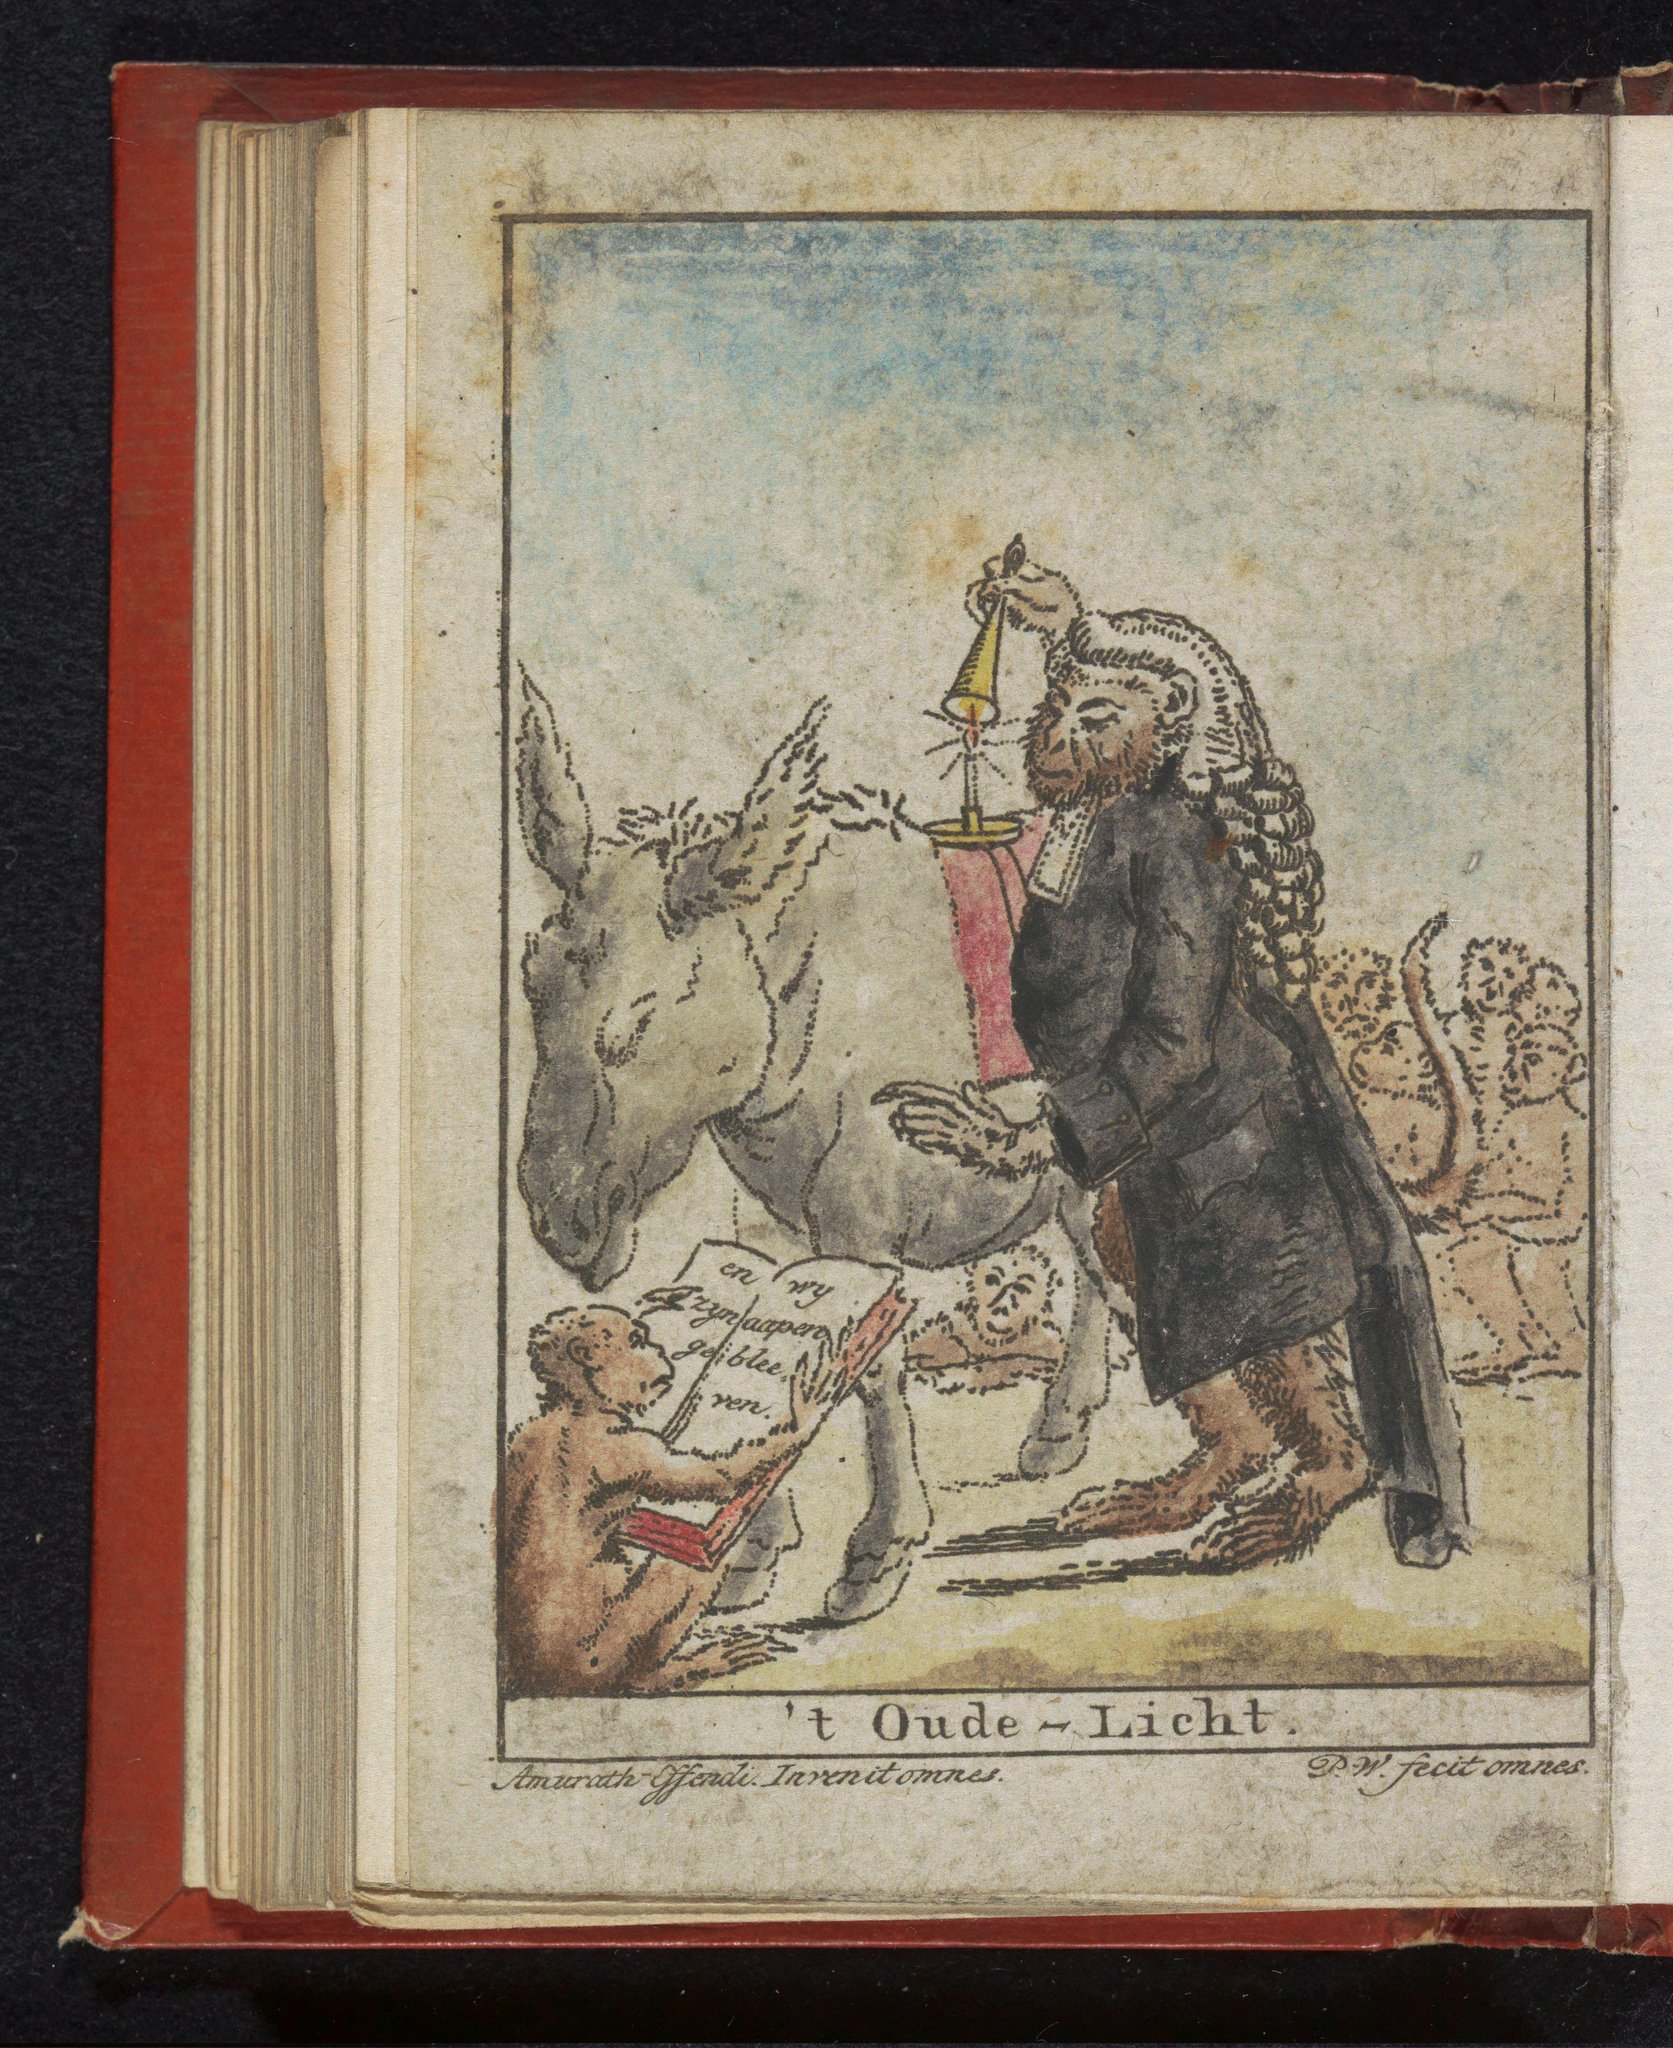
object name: print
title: 't Oude-Licht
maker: pieter van woensel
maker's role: print maker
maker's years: 1747-1808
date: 1795-1796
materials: paper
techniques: etching, hand coloring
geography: netherlands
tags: ass, donkey, monkeys, apes, animals acting as human beings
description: Spotprent waarin een aap met pruik en domineesmantel de kaars op de rug van ezel uit doet. Apen kijken toe. Illustratie in Pieter van Woensels almanak 'De Lantaarn voor 1796'.